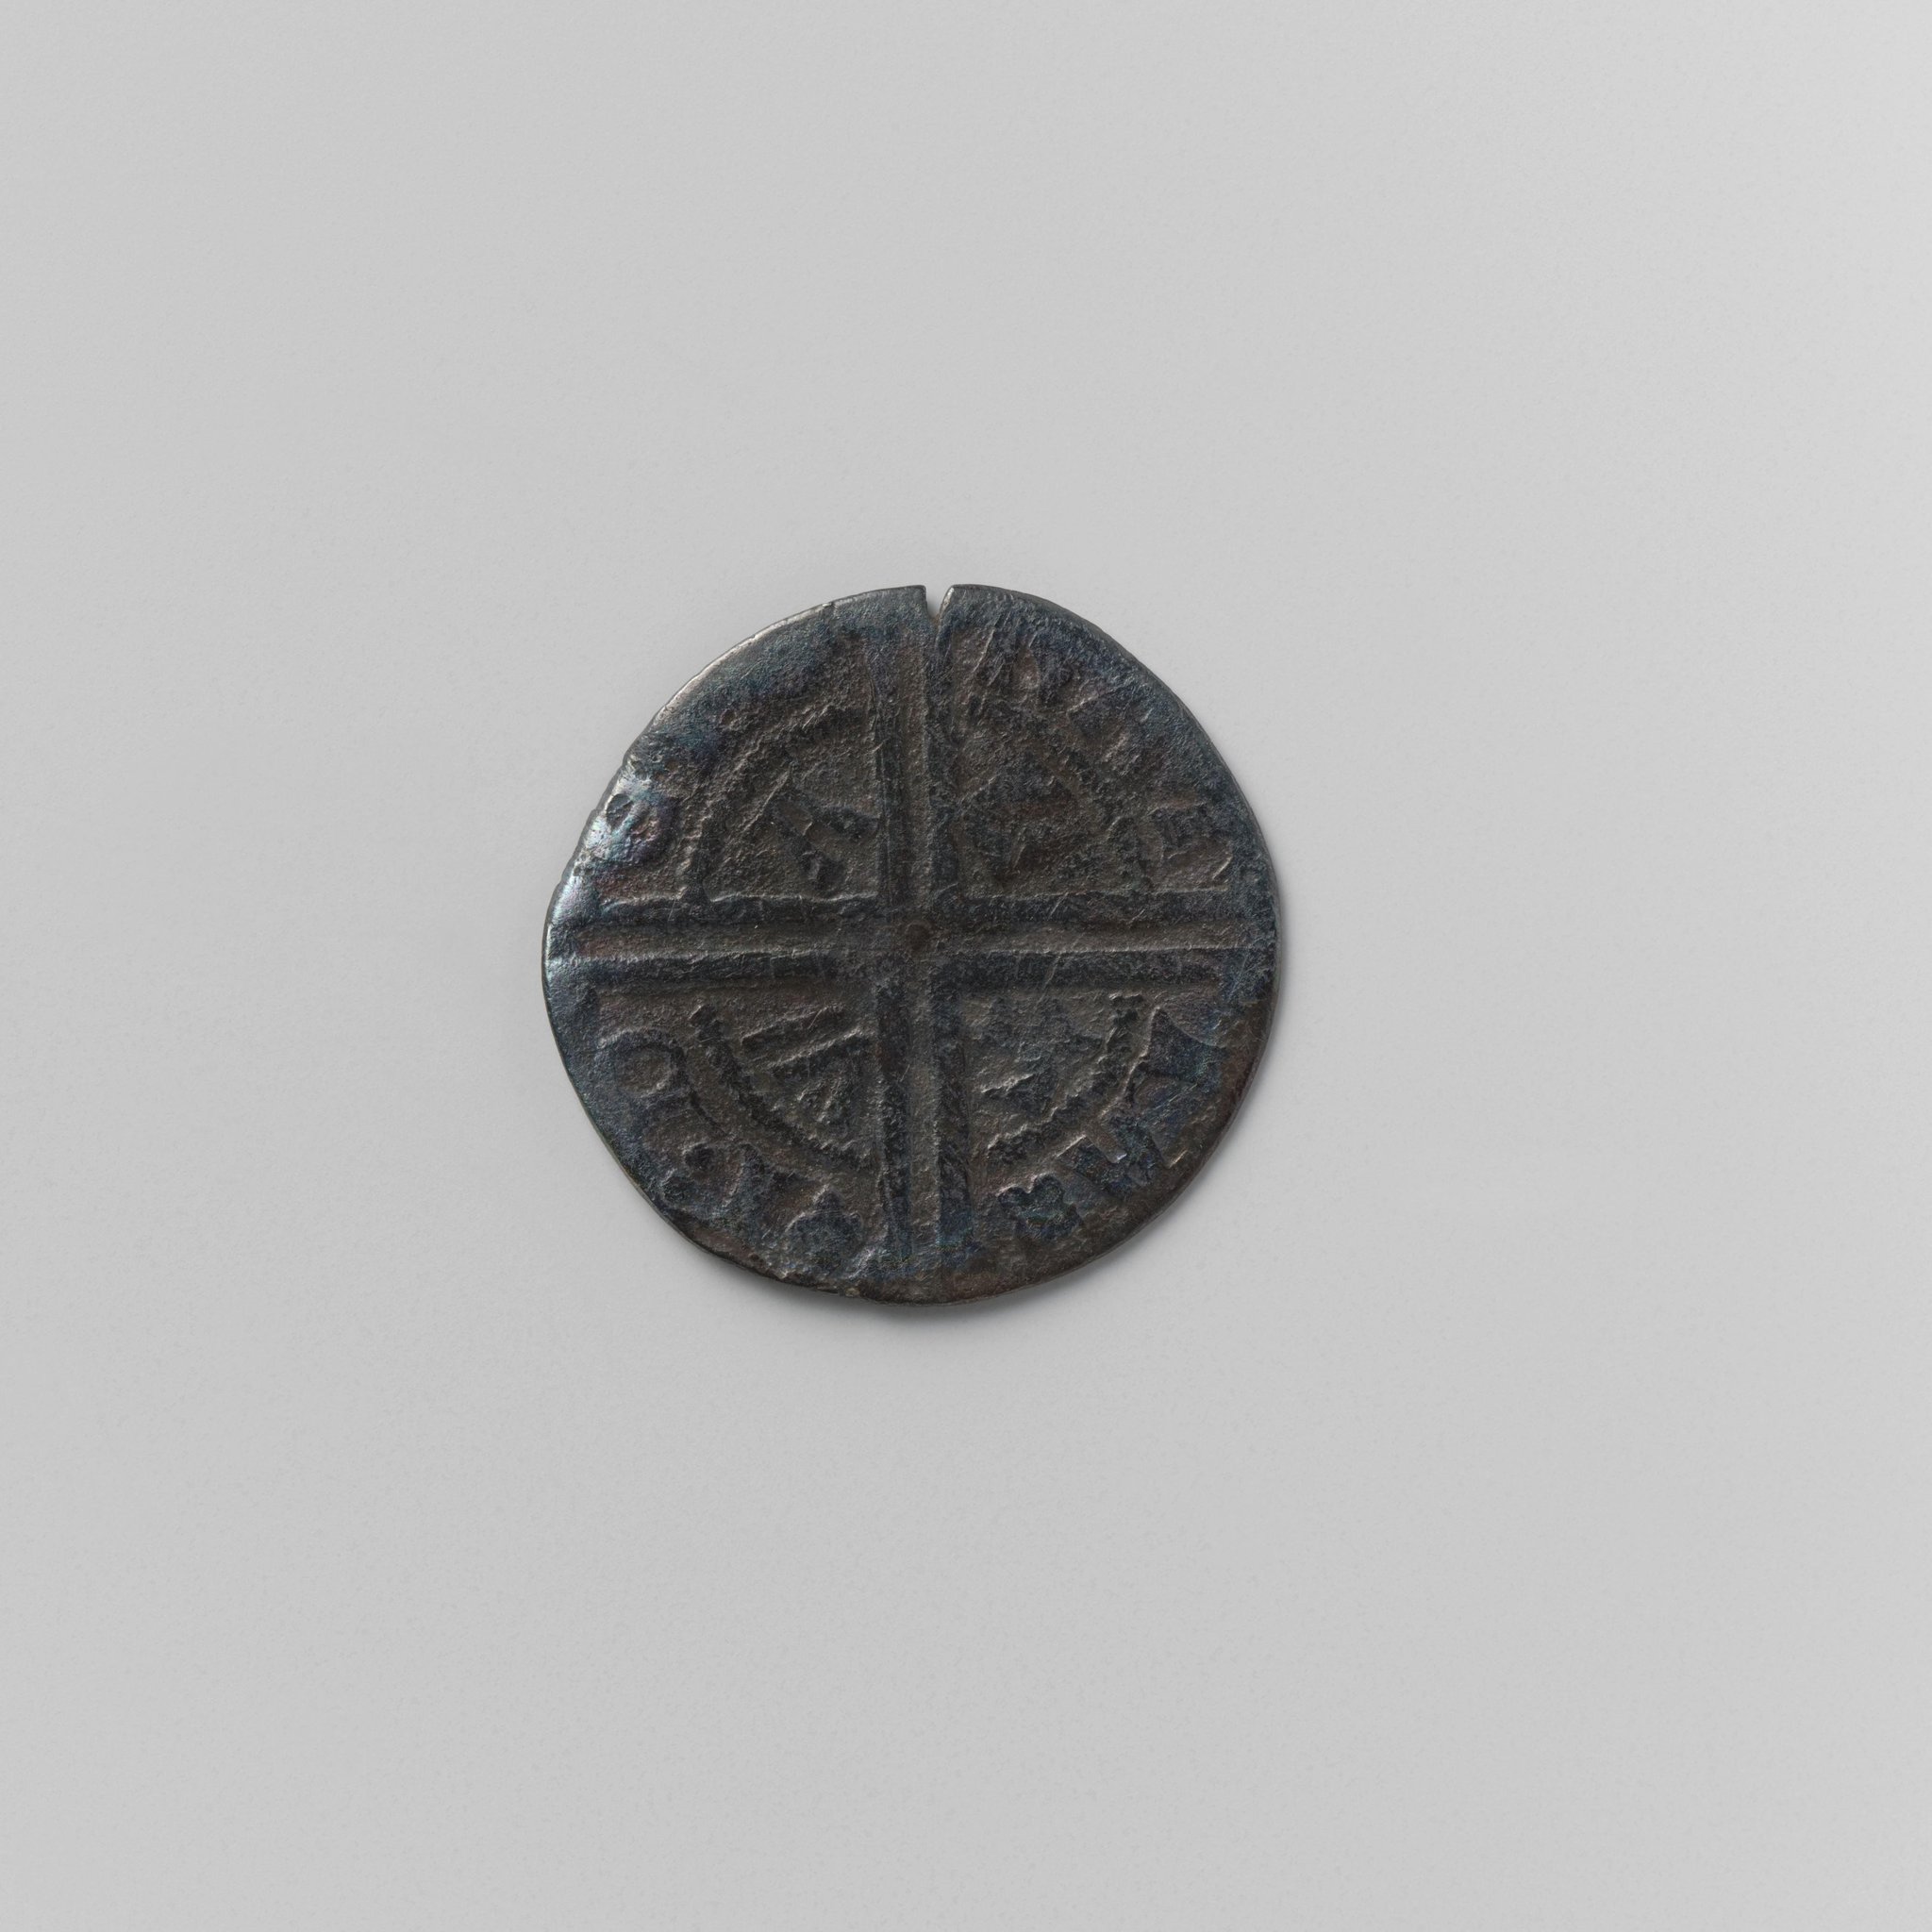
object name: coin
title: Sterling uit Brabant van Jan I, 1268-1294, op naam van Walter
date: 1277-1294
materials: silver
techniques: striking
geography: brussels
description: Voorzijde: in een punt uitlopend wapenschild met leeuw, waaromheen omschrift. Keerzijde: lang dubbellijnig kruis, in de hoeken letters W,A,L en T. Daaromheen omschrift.